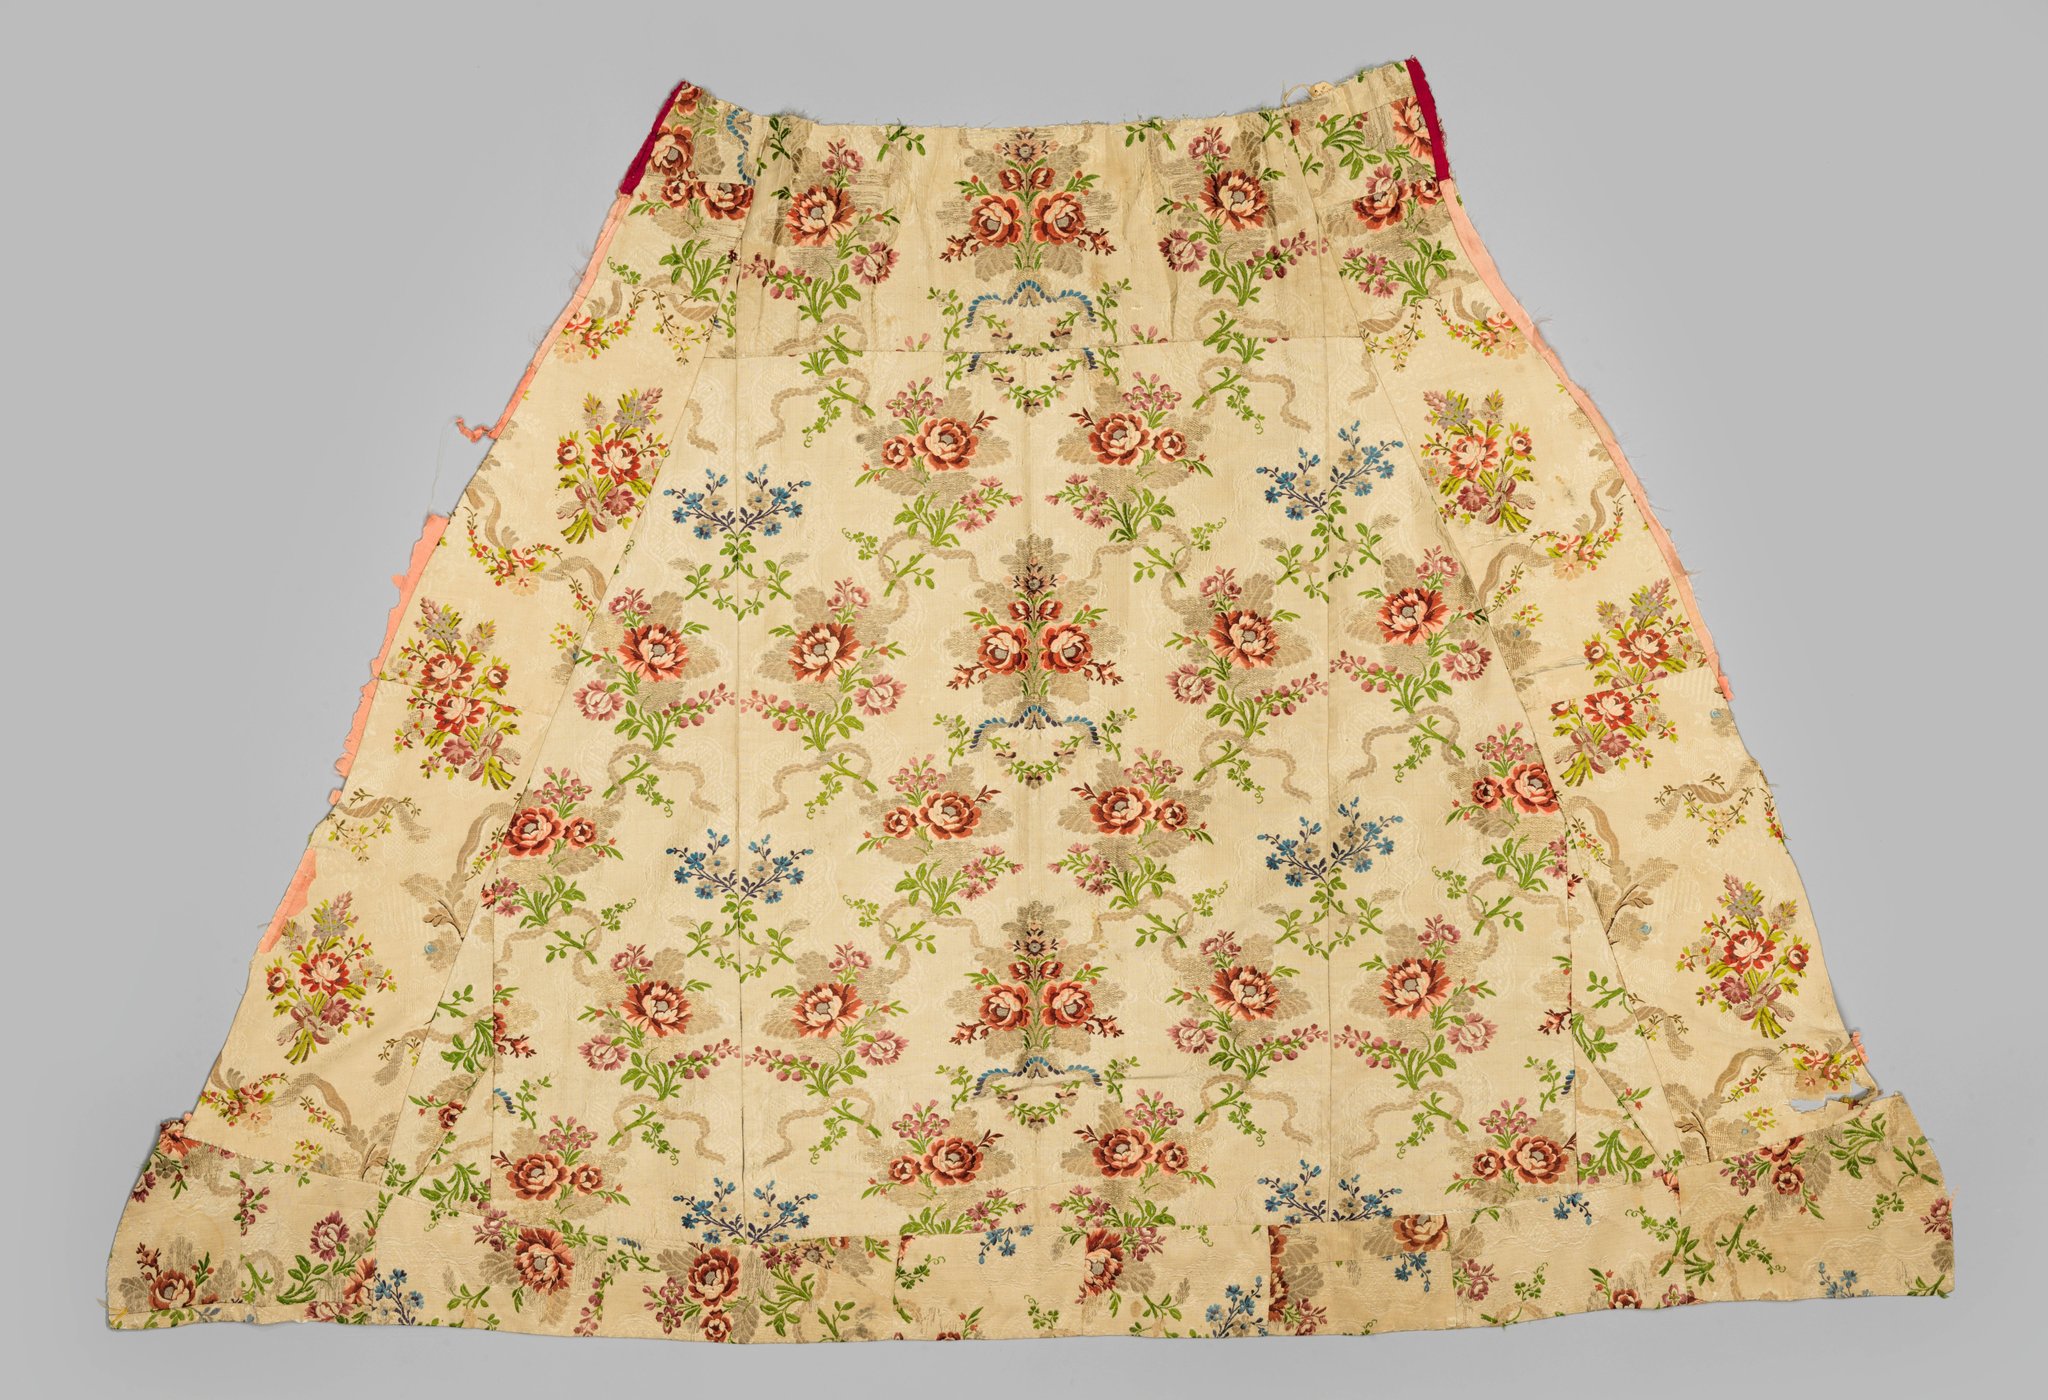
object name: silk textile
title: Zijdeweefsel van gebrocheerde zijde, samengesteld uit tweeëndertig aan elkaar genaaide fragmenten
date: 1760-1765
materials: gold thread, silk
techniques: brocade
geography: france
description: Zijdeweefsel van gebrocheerde zijde, samengesteld uit tweeëndertig aan elkaar genaaide fragmenten. Langs de randen resten van roze zijden voering. Dessin: in horizontale rijen geplaatste tuilen met rozen in twee kleuren roze/rood, lila, groen en twee kleuren blauw (brochering) en in goud (liseré), afgewisseld door takken met blauwe bloemen in twee kleuren blauw (brochering) en in goud (liseré). Mogelijk cape voor een Mariabeeld. Aan achterzijde label waarop gedrukt: French and Co. inc. en geschreven: 21927, Price 275. Aan bovenzijde een linnen label met opschrift # 21927, Fragment Antique Brocade Selling Price # 150, met een breukgetal en opgestempeld weer het nummer 21927. Opgespeld briefje met de letter R.